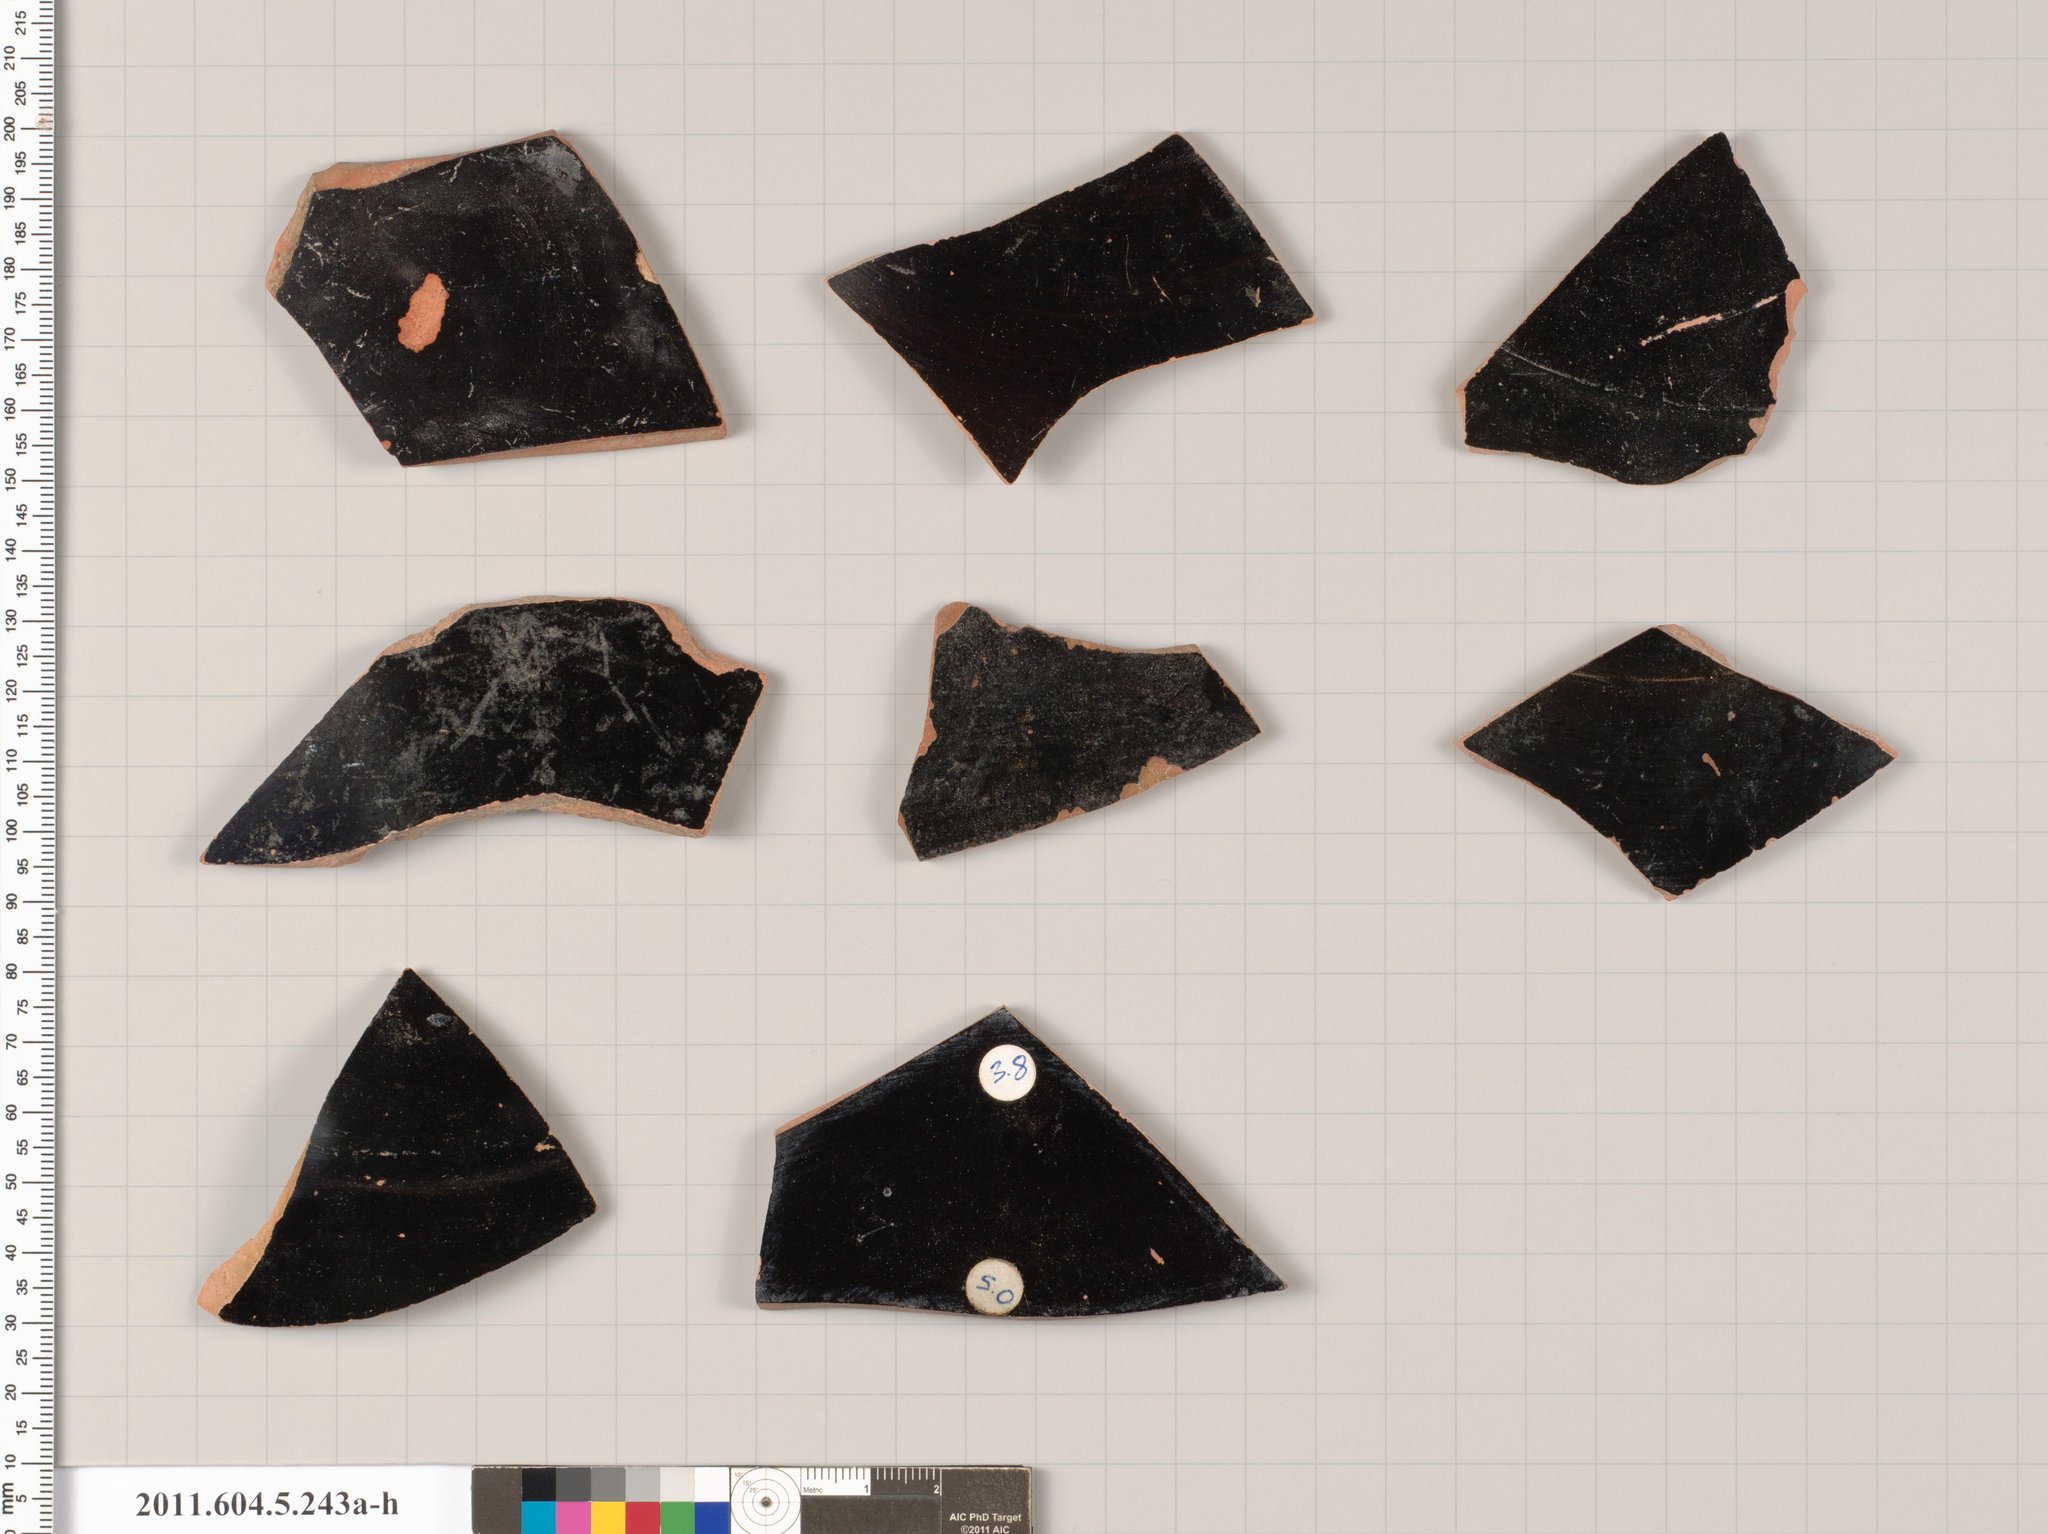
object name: kylix fragment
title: Terracotta fragments of kylikes (drinking cups)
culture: greek, attic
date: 600-401 BCE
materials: terracotta